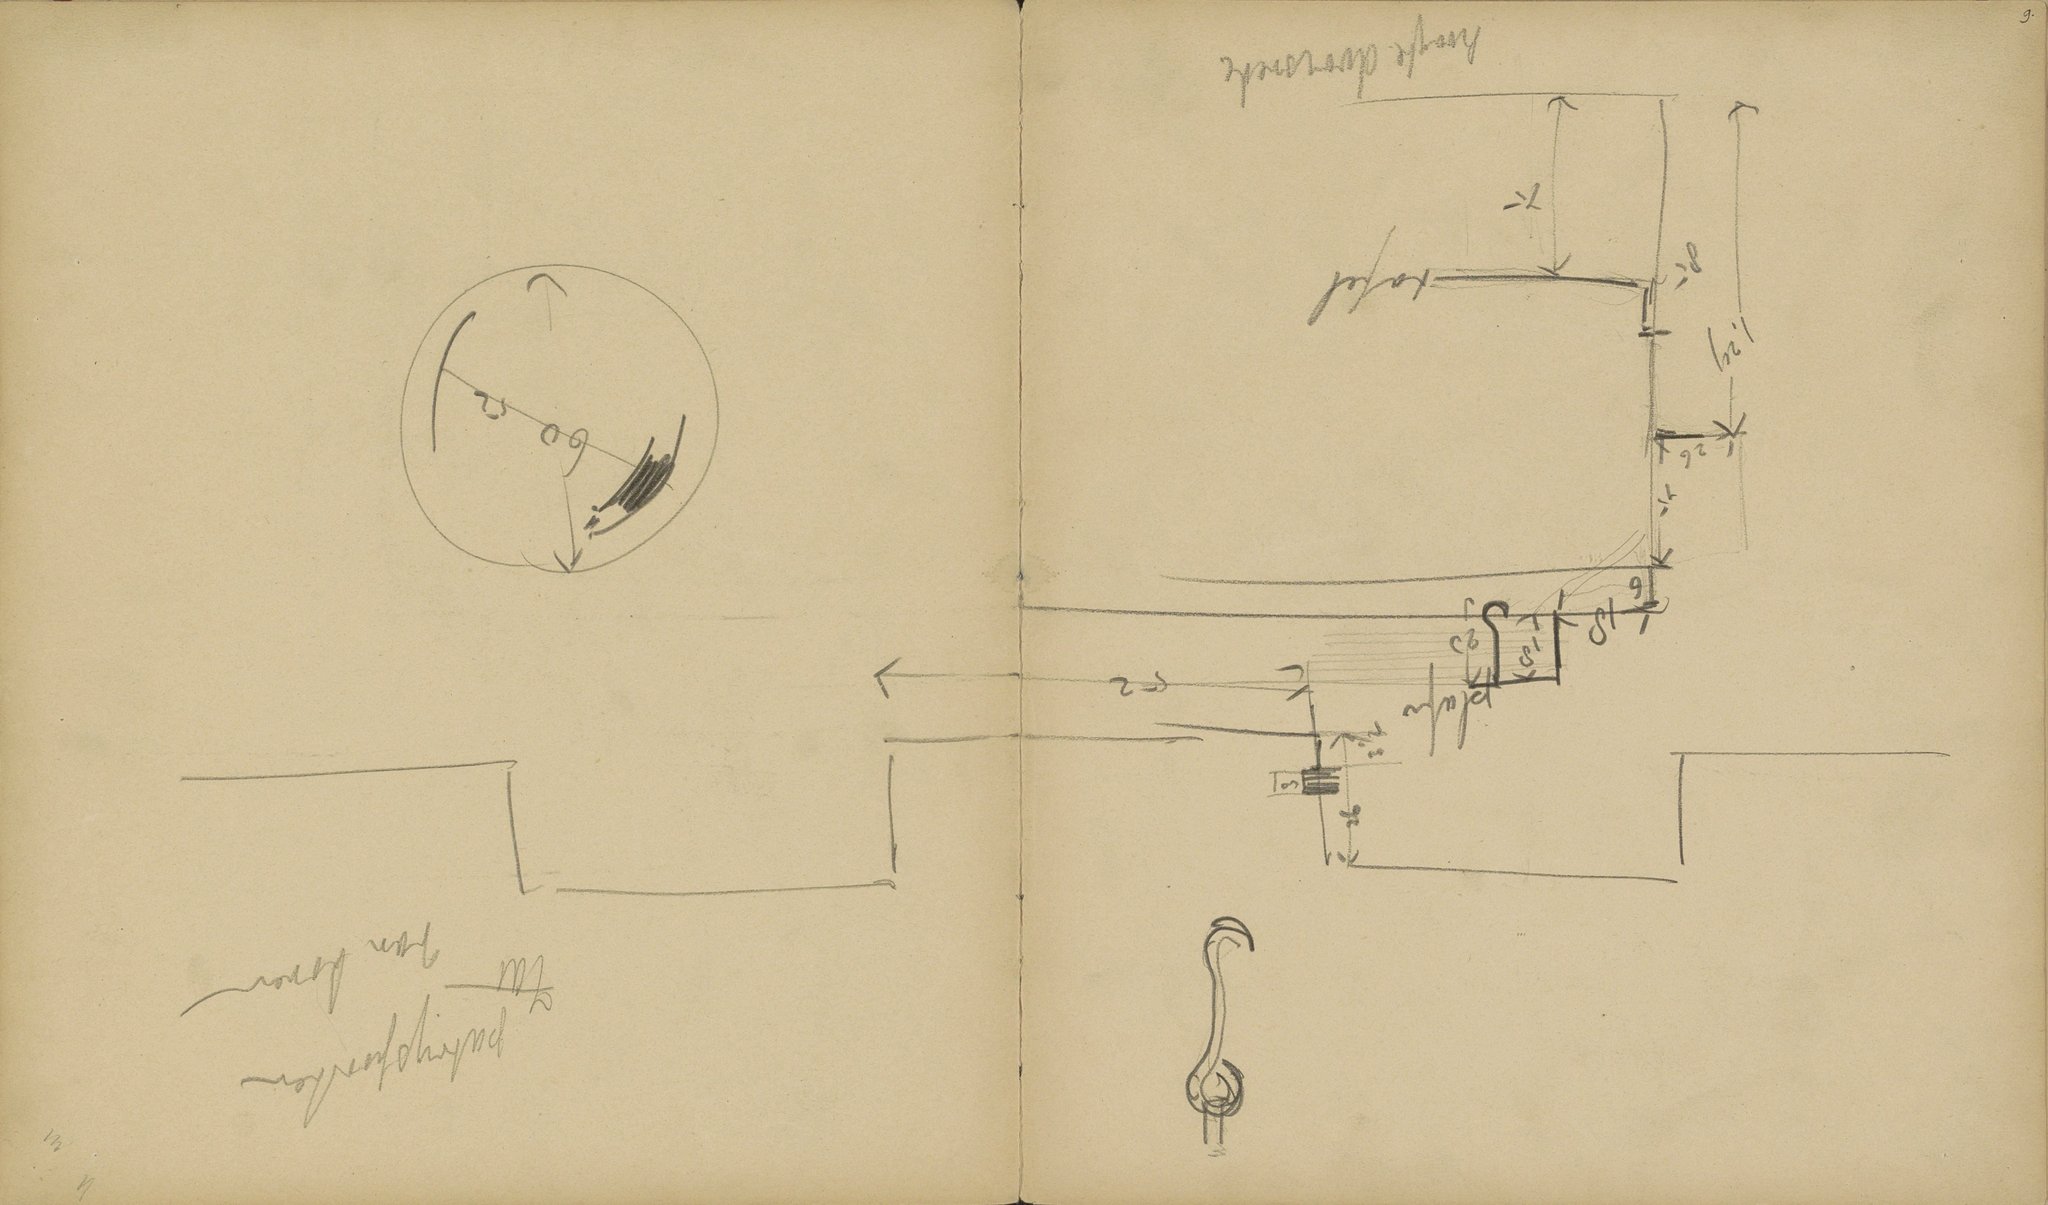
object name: sketchbook leaf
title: Patrijspoort en een plattegrond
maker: carel adolph lion cachet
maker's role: draughtsman, print maker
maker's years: 1864-1945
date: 1906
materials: paper, pencil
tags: parts of ship's exterior, plan ~ architecture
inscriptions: annotation: ‘patrijspoorten/ van boven/ hoogte doorsnede’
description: Blad 8 verso en 9 recto uit een schetsboek met 27 bladen.